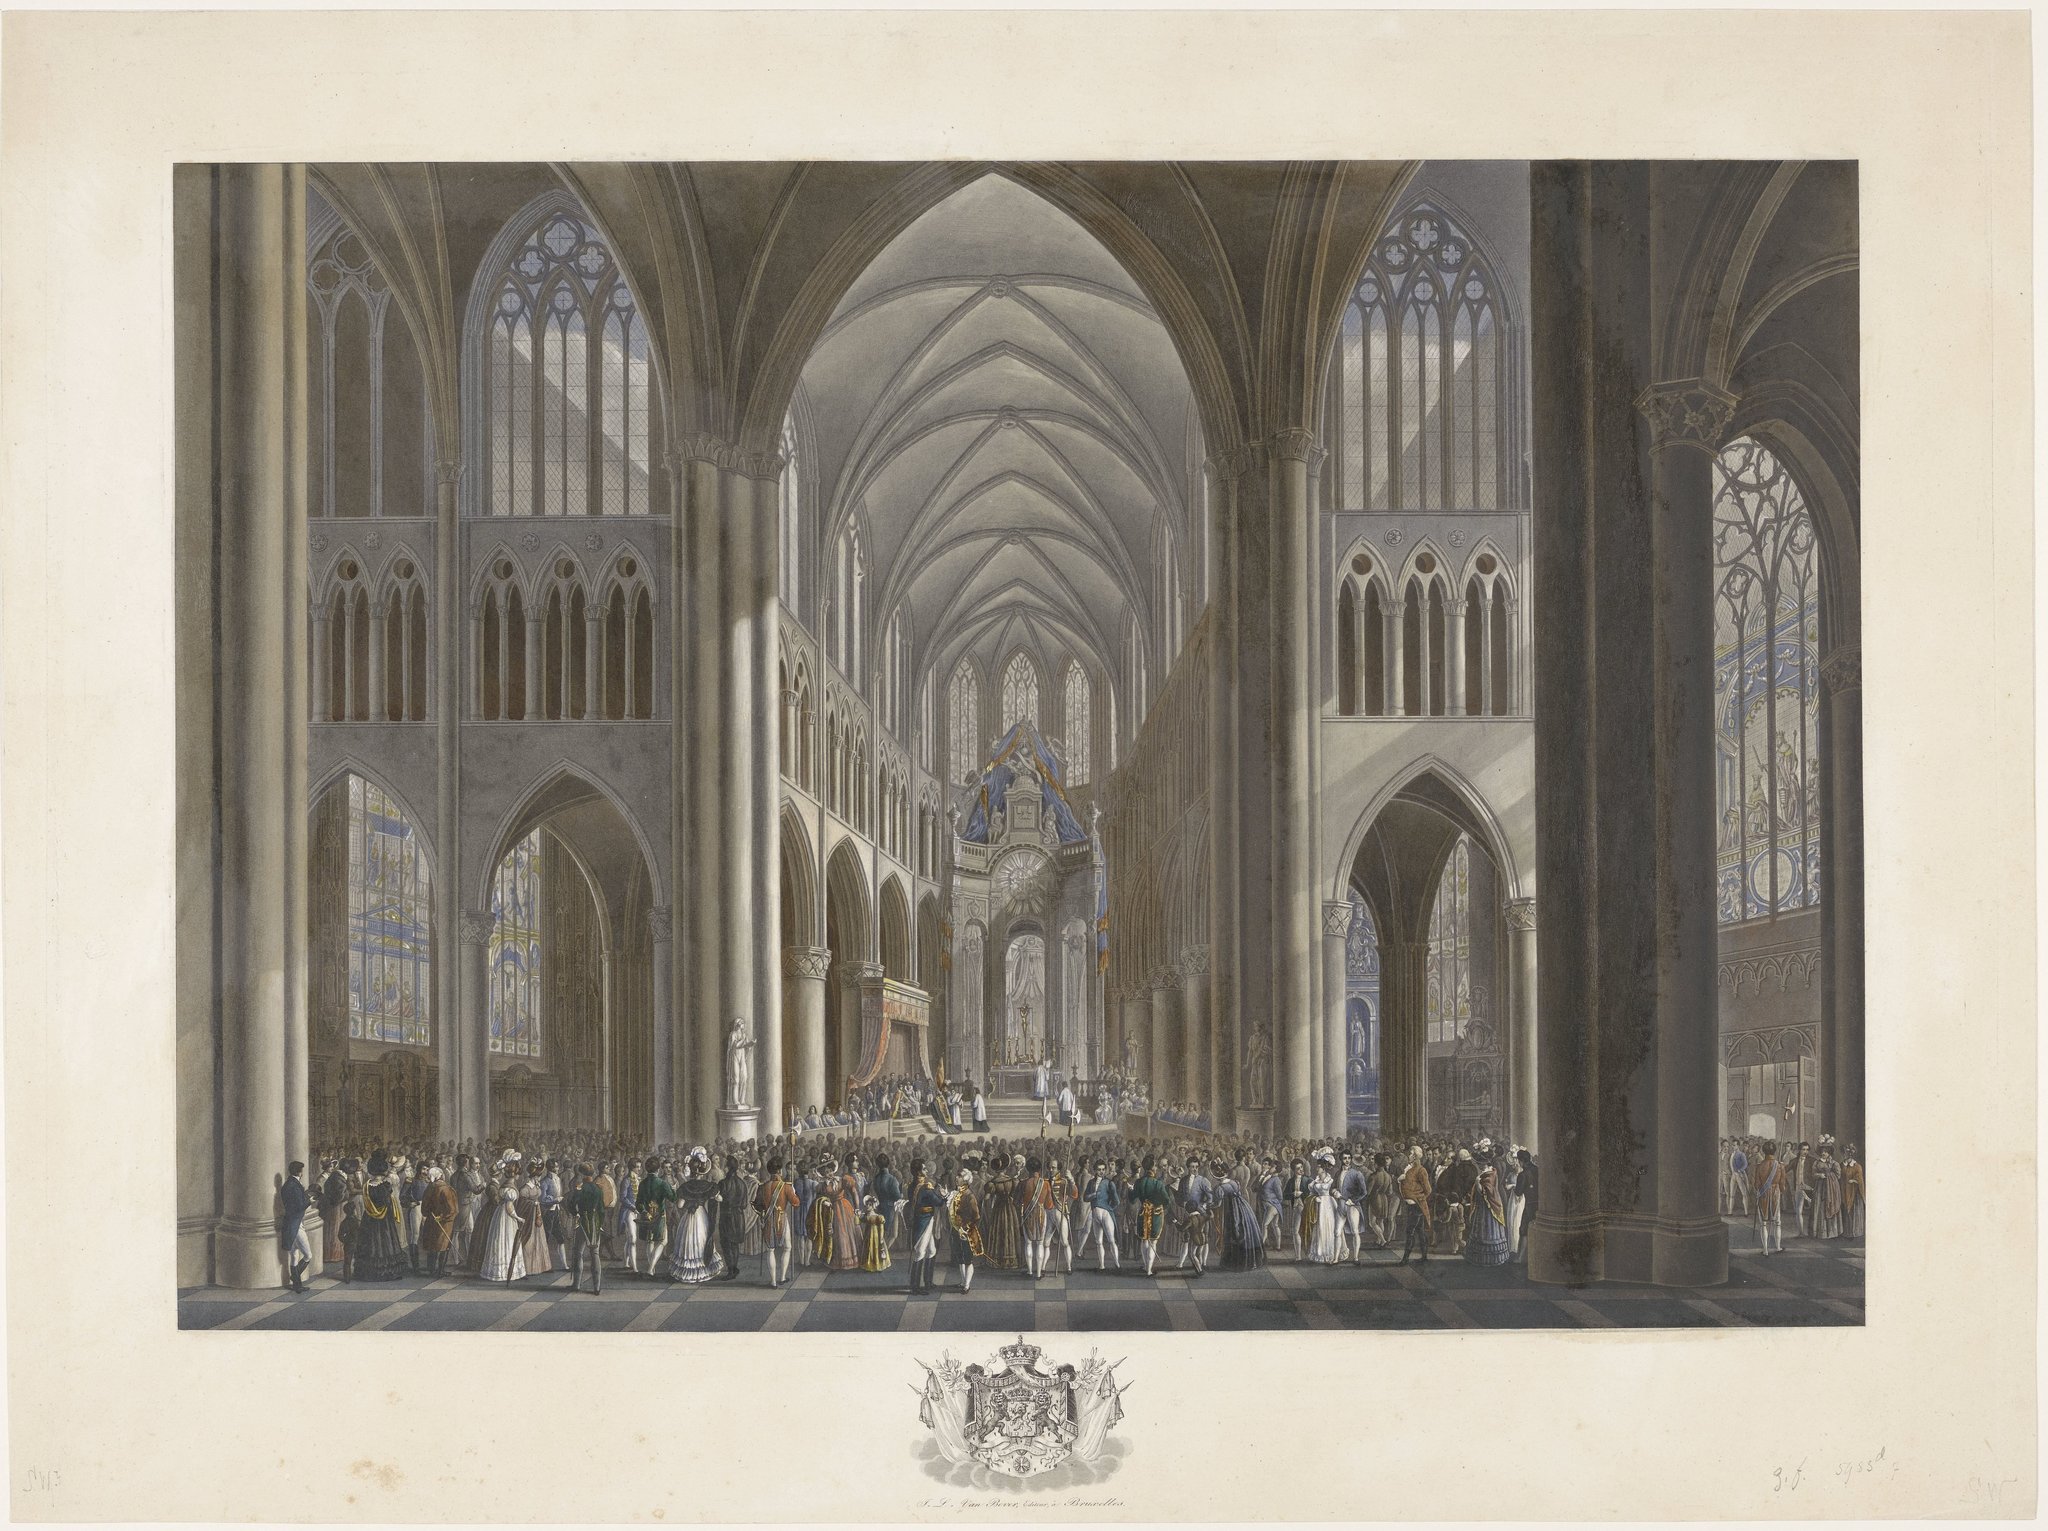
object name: print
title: Inzegening van koning Willem I in de Sint-Goedelekerk te Brussel op 21 september 1815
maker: johann nepomuk gibèle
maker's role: print maker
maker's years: 1775-1836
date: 1825-1826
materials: paper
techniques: aquatint, etching, hand coloring, lacquer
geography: brussels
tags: the hague, berlin, william i of the netherlands, ceremonial celebration of installation of a ruler, interior of church, brussels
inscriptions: collector's mark: Lugt 2228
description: Inzegening van koning Willem I na de inhuldiging in de Sint-Goedelekerk (de huidige Kathedraal van Sint-Michiel en Sint-Goedele) te Brussel op 21 september 1815. Kerkinterieur met de koning zittend op een verhoging links van het hoofdaltaar. Onderaan het wapen van koning Willem I. Onderdeel van een serie platen van de aankomst en inhuldiging van Willem I in Brussel.